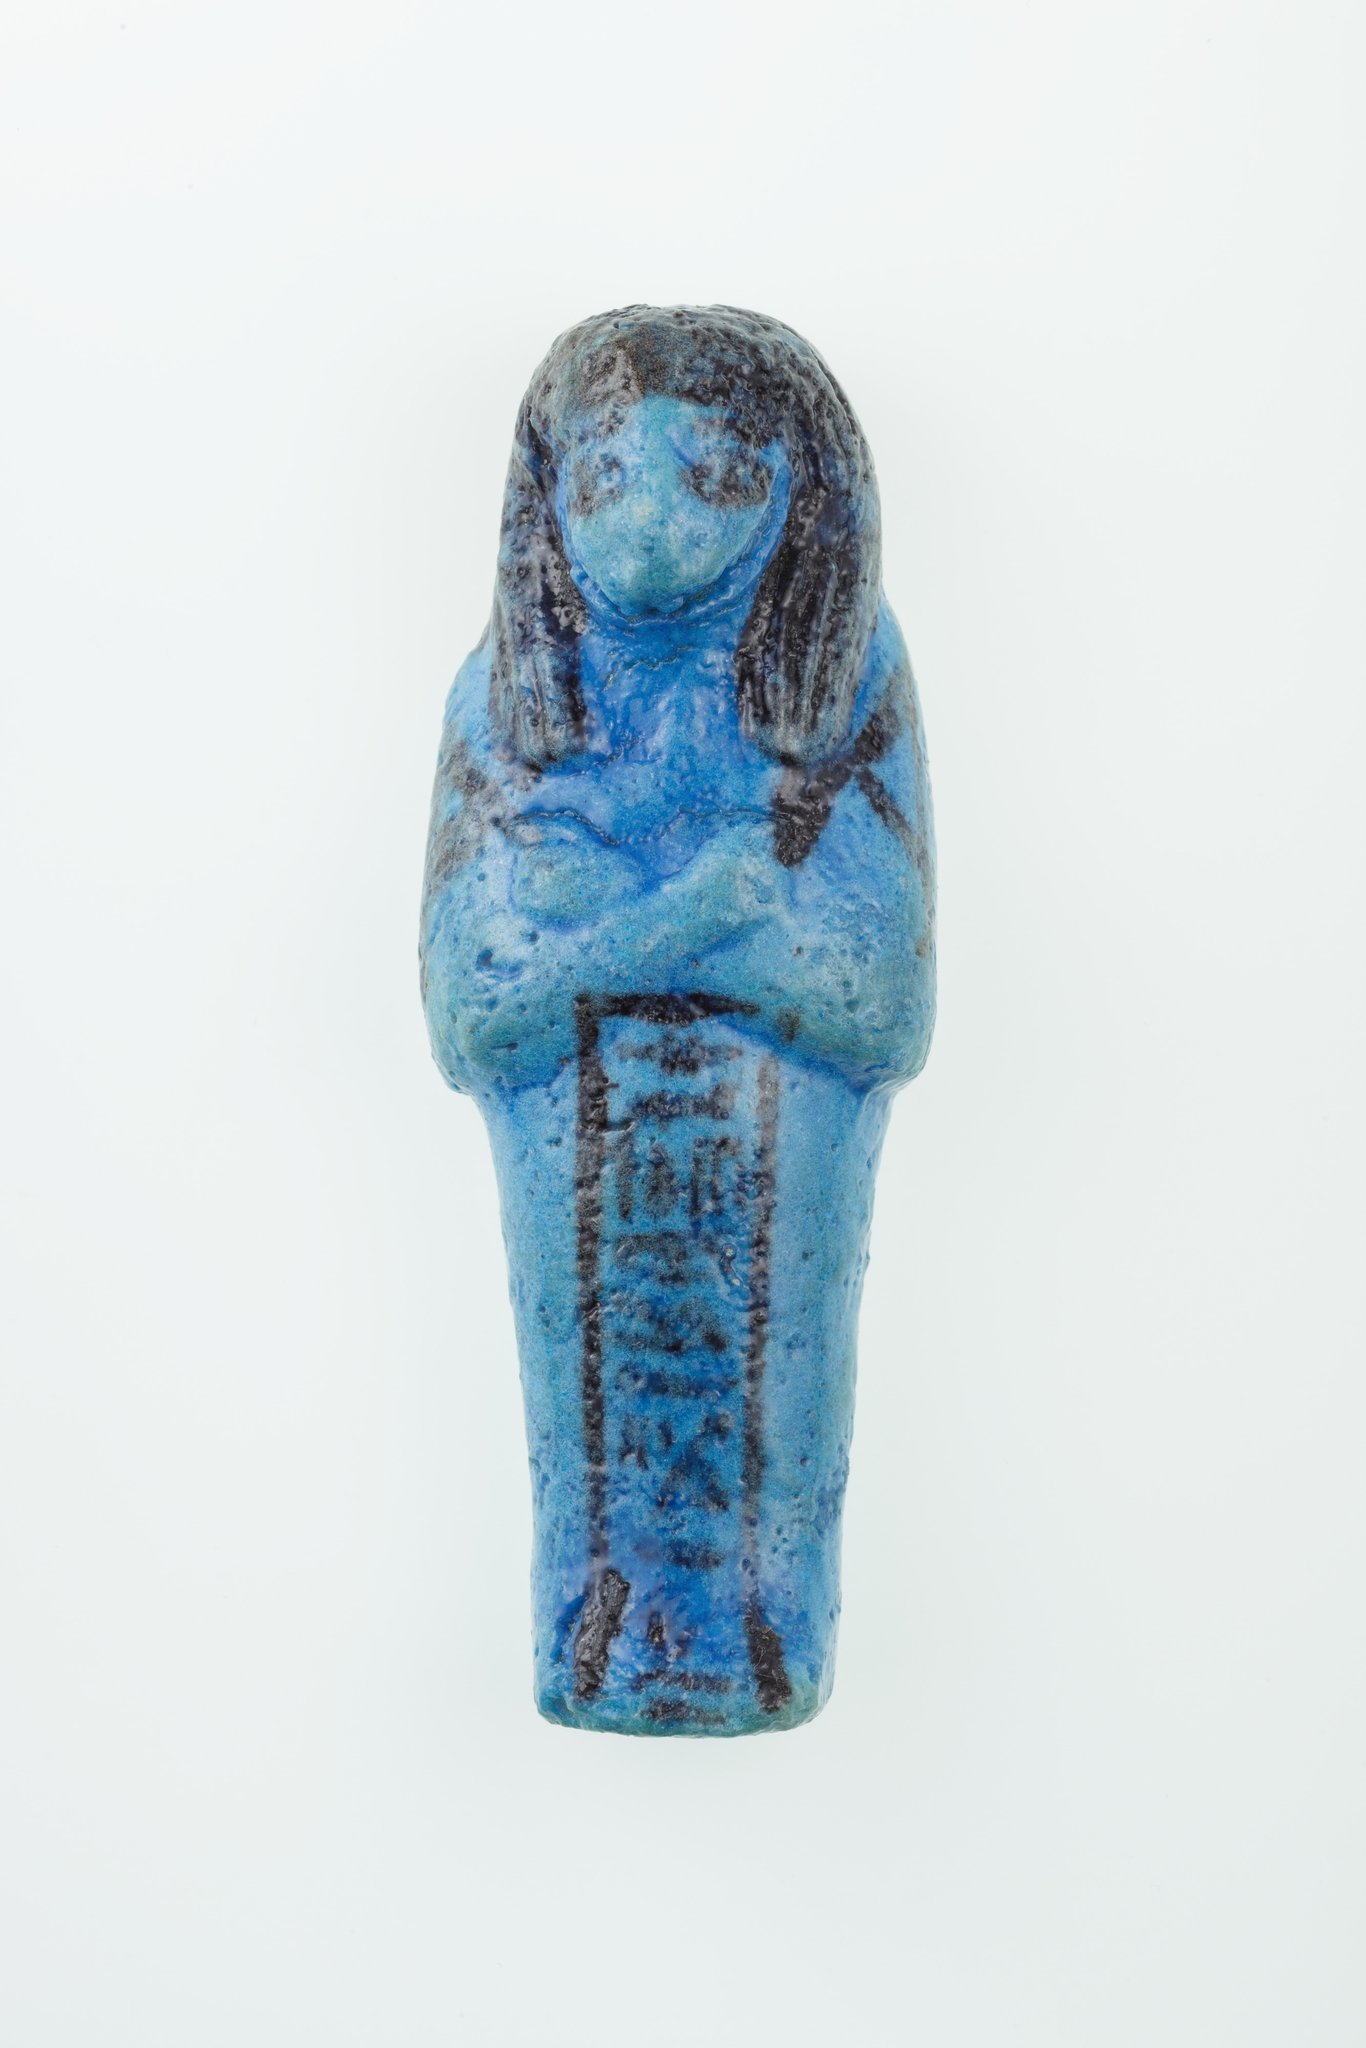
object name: shabti, worker, nauny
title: Worker Shabti of Nauny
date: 1050 BCE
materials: faience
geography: egypt